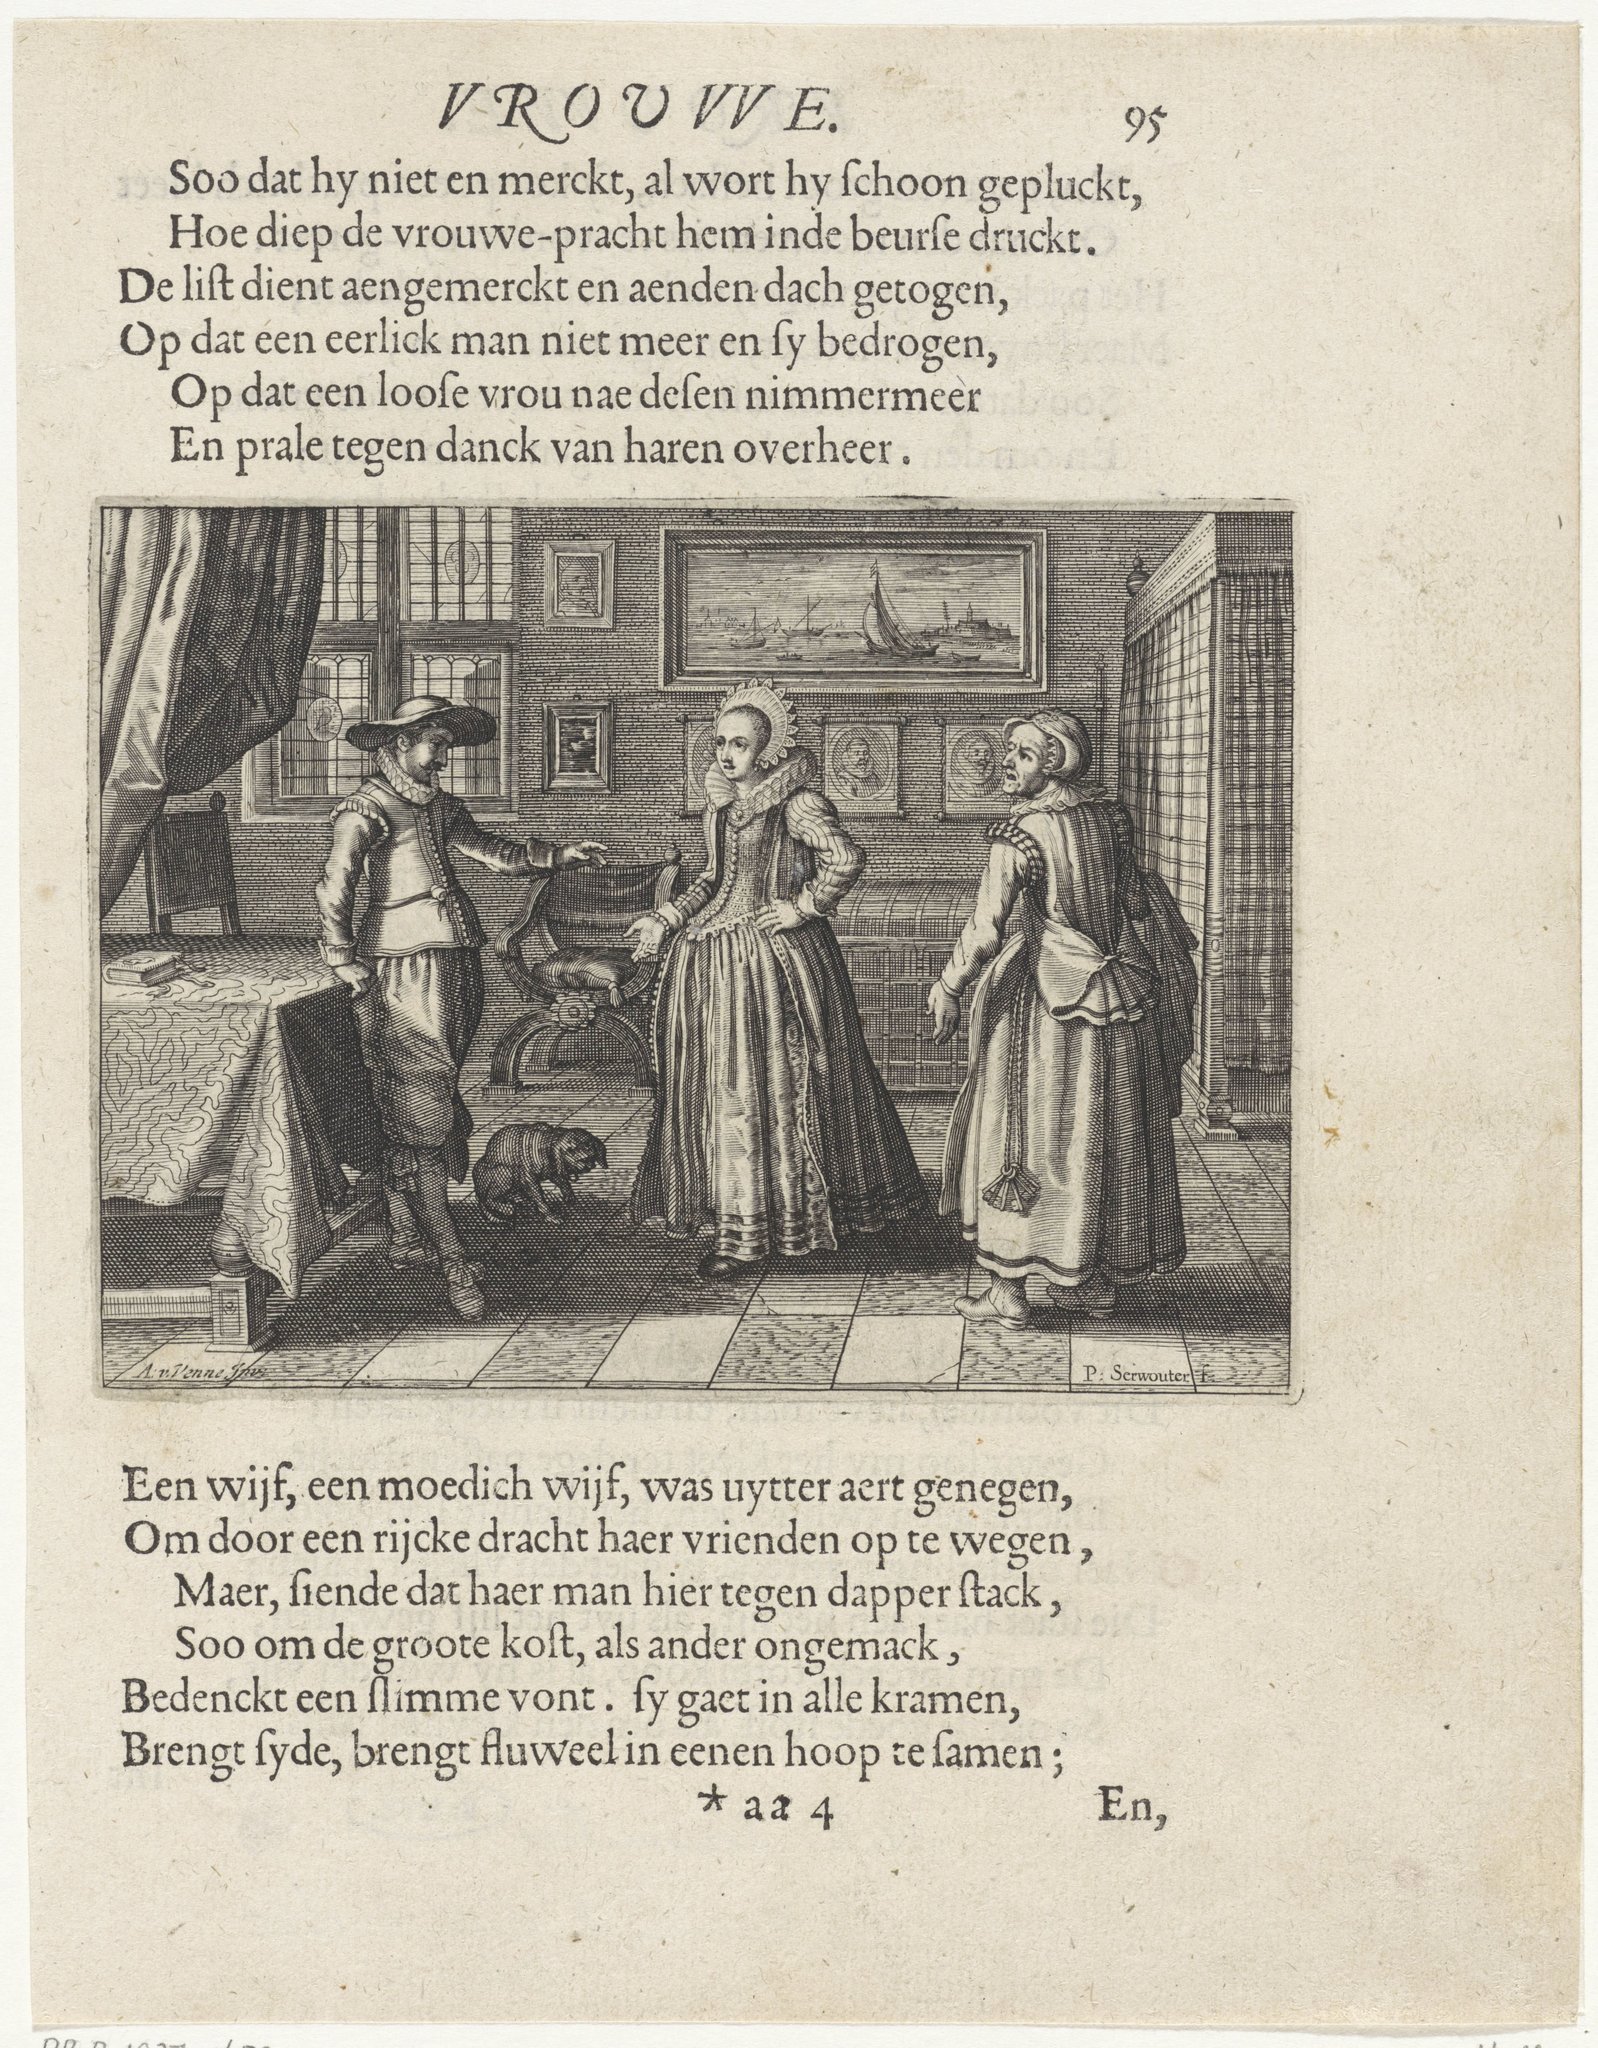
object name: book illustration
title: Paar en bediende in een interieur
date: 1625-1633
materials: paper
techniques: engraving, letterpress printing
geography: amsterdam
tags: bed with tester, picture, painting, quarrel, argument, living-room, parlour, sitting-room, dog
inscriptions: collector's mark: Lugt 2760, collector's mark: Lugt 2228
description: Rechts in het vertrek een hemelbed. tegen de achterwand hangt een schilderij met zeilschepen en hangen portretten. Met tekst over de dure kleding van de vrouw: Soo dat hij niet en merckt, al wort hij schoon gepluckt,/Hoe diep de vrouwe-pracht hem inde beurse druckt....